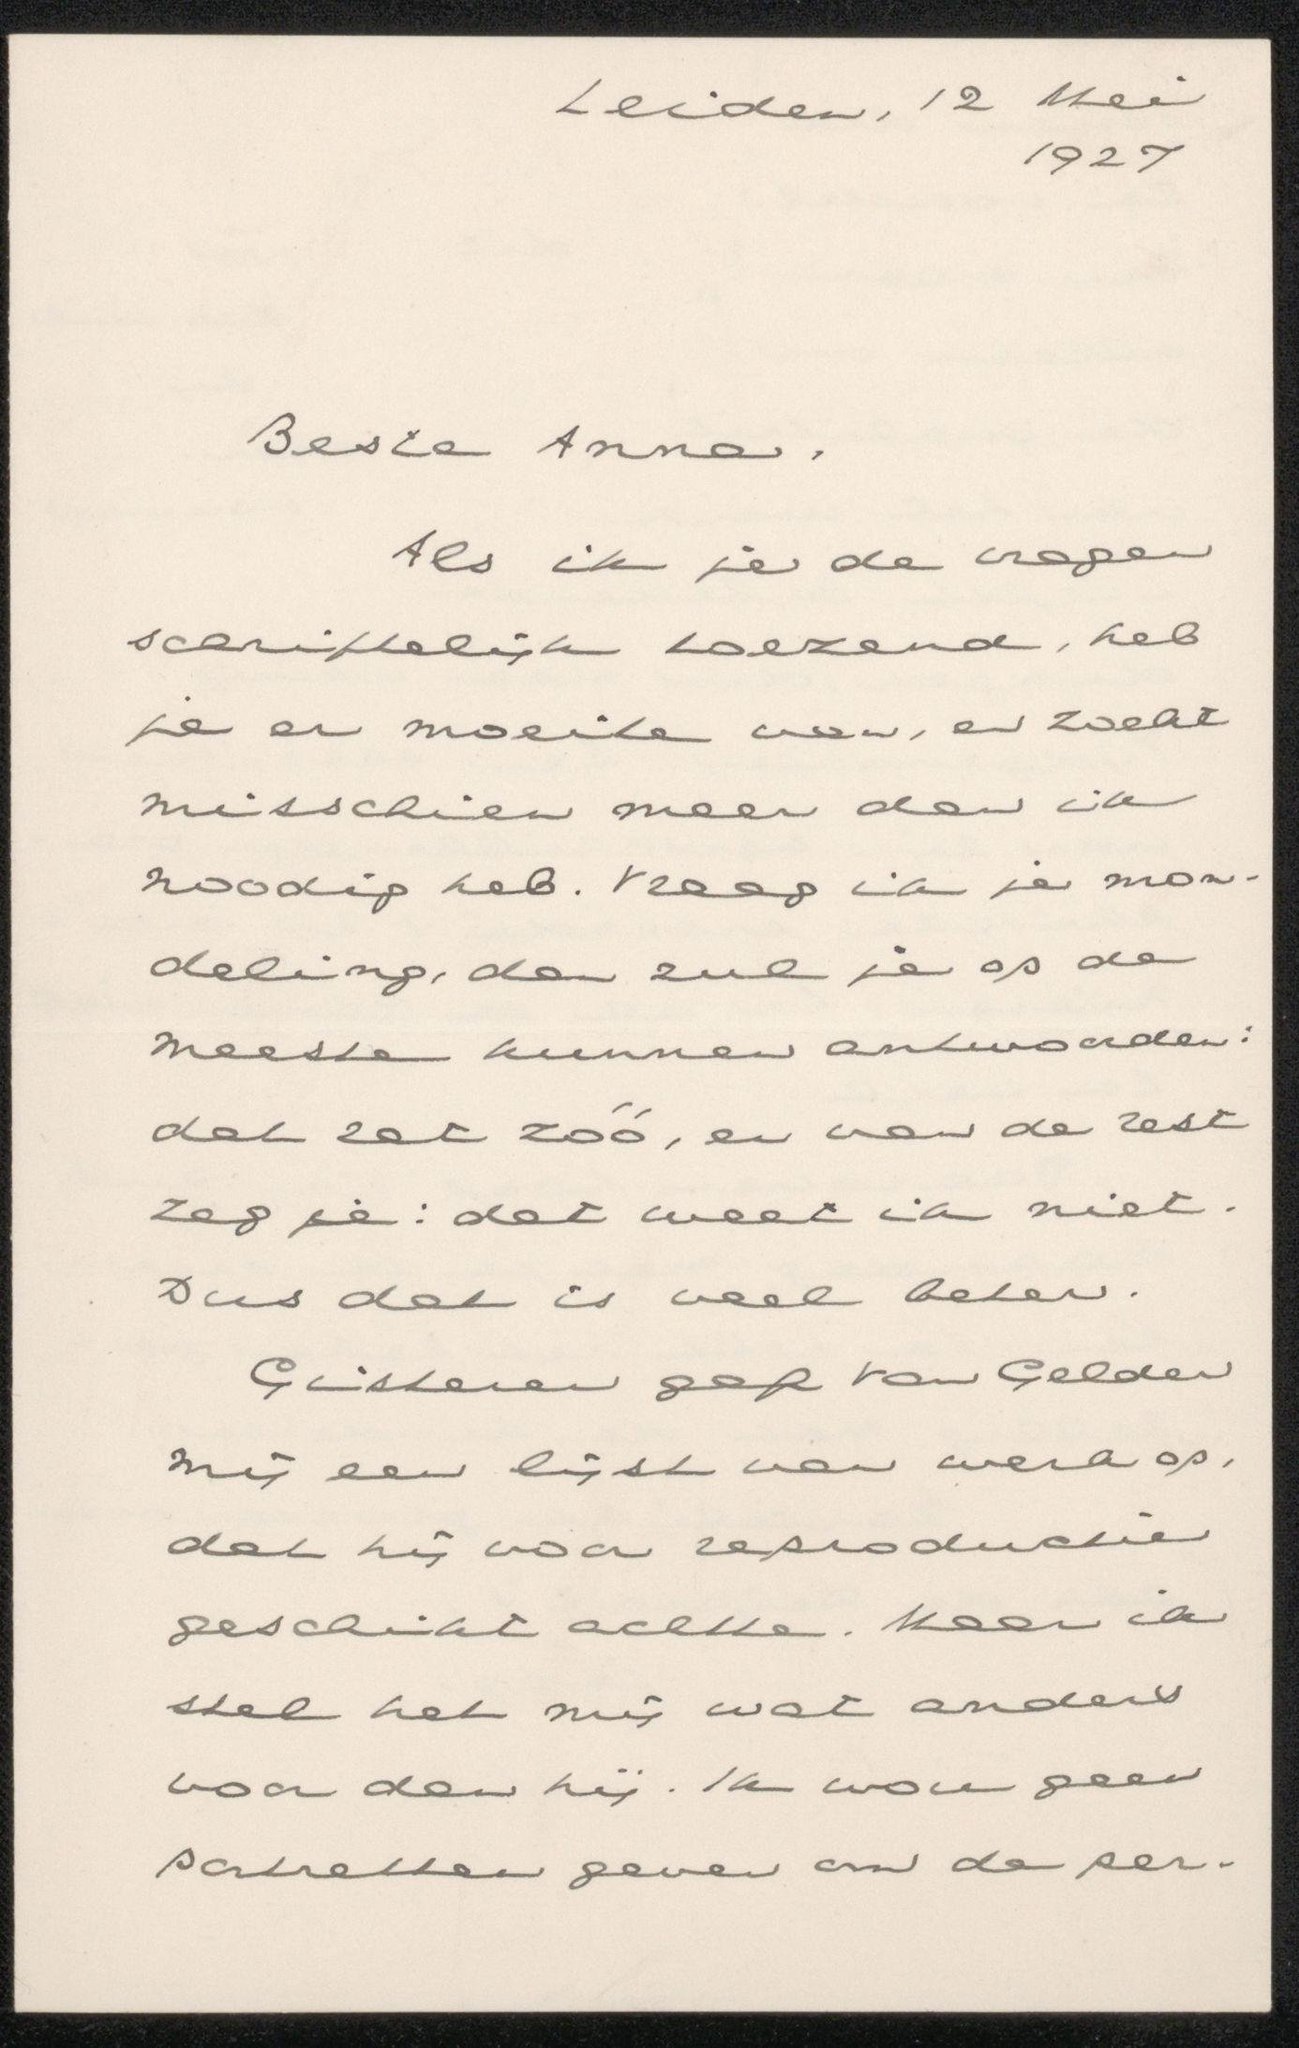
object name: letter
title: Brief aan Anna Dorothea Dirks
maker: johan huizinga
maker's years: 1872-1945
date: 1927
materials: ink, paper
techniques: pen, writing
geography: leiden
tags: artist, anna dorothea dirks, the hague, hendrik enno van gelder, illustration ~ printed matter, book, historical persons (portraits and scenes from the life)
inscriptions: collector's mark: ‘RPK’, watermark